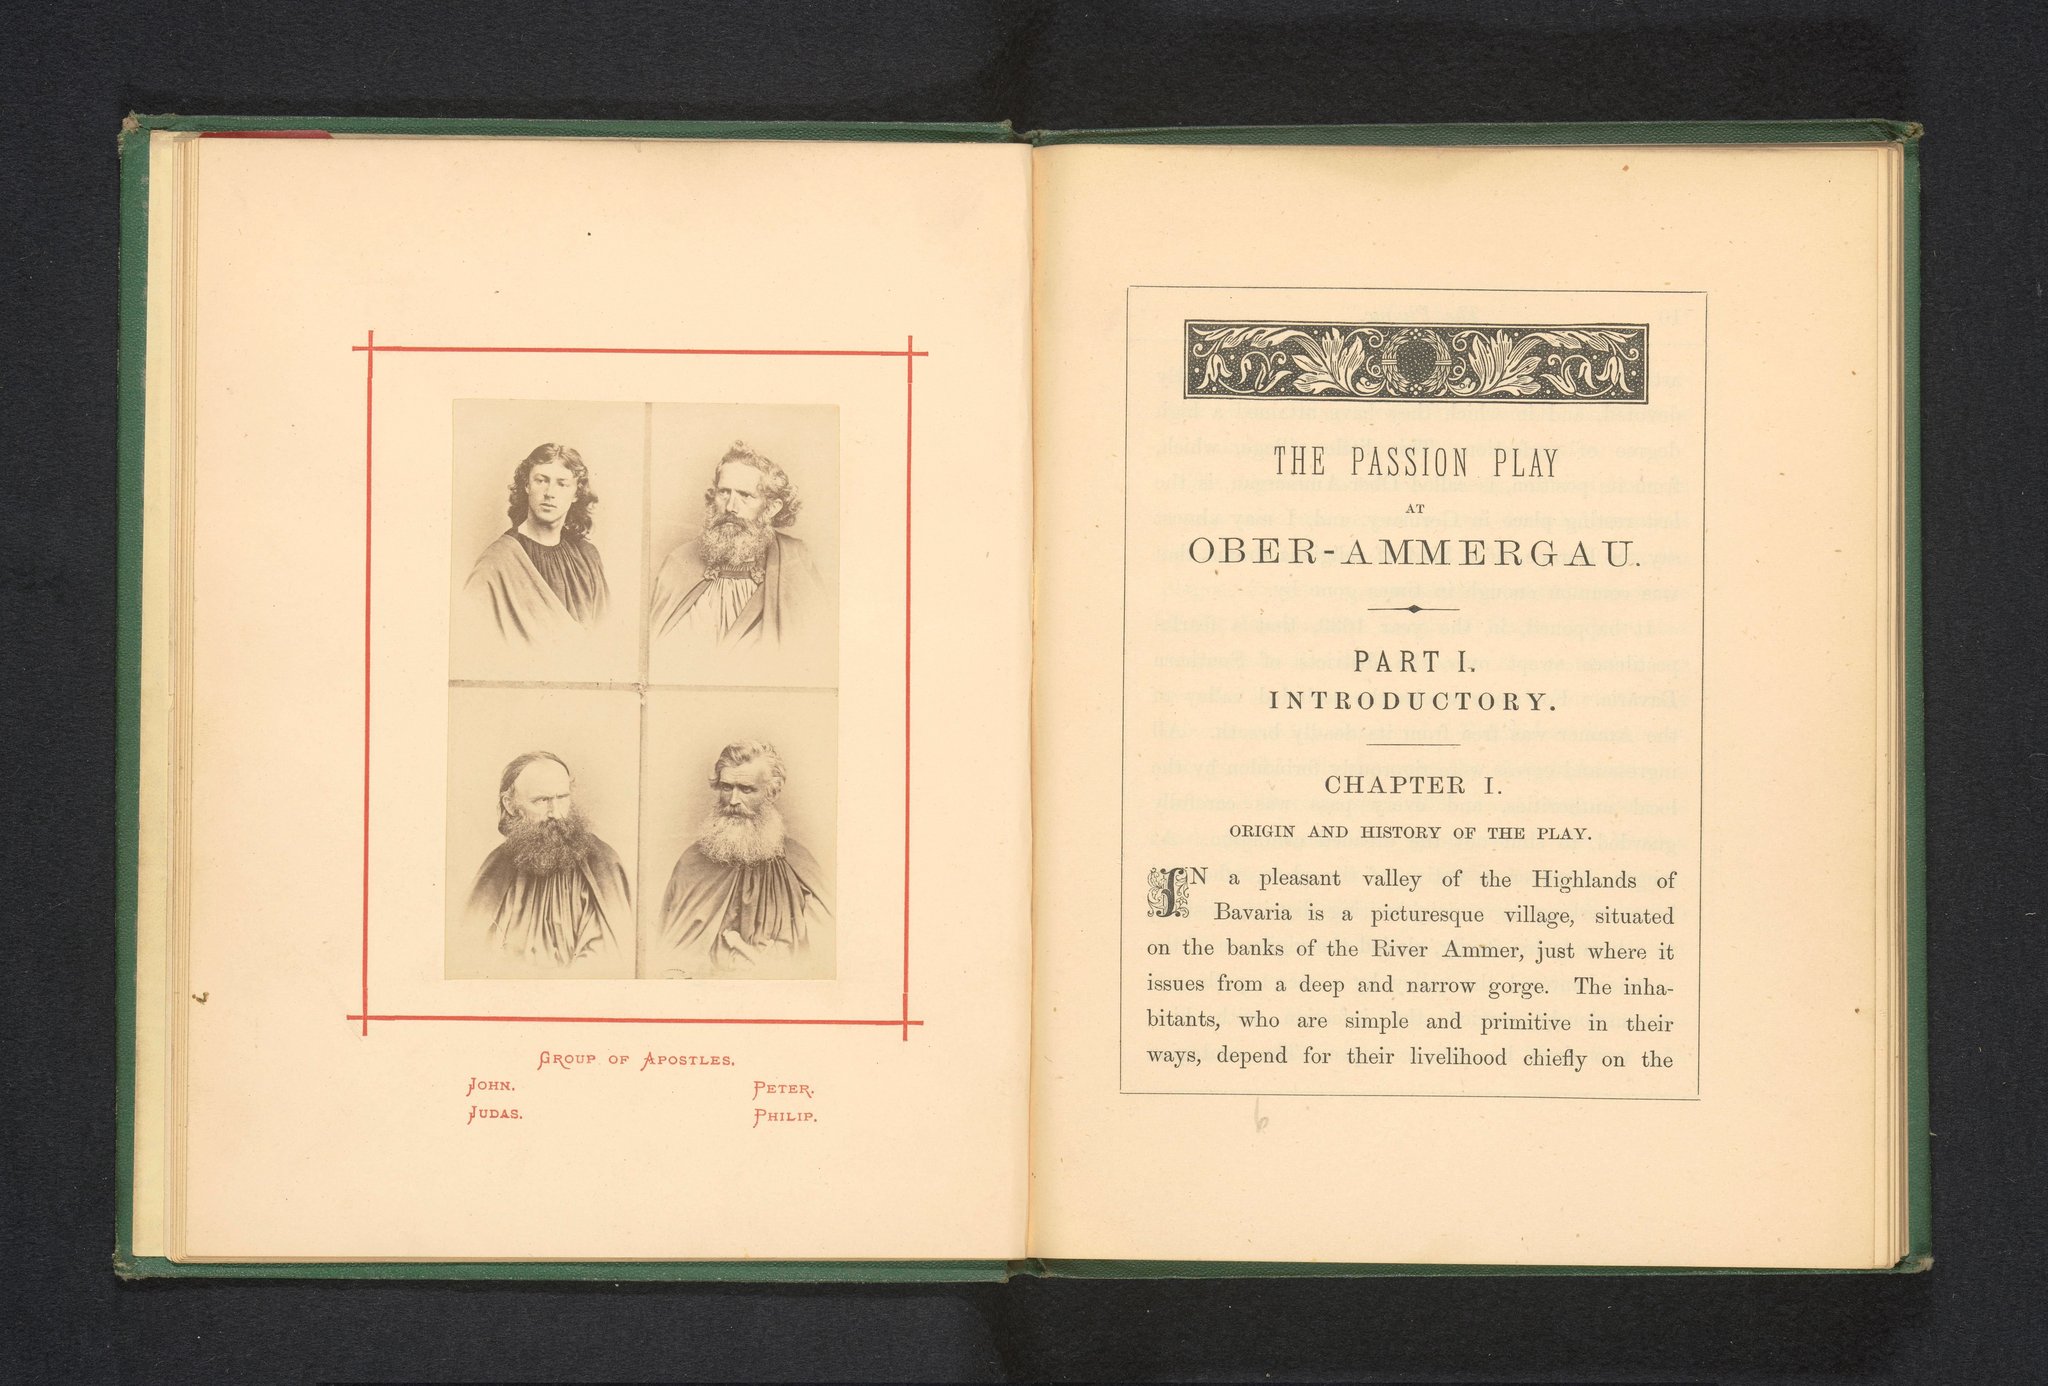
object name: page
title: Vier portretten van onbekende acteurs als apostelen uit de Passie in Oberammergau in 1871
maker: joseph albert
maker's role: printer, publisher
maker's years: 1825-1886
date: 1867-1872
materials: photographic support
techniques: albumen print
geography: oberammergau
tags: other groups of apostles, passion of christ, historical persons not known by name, oberammergau